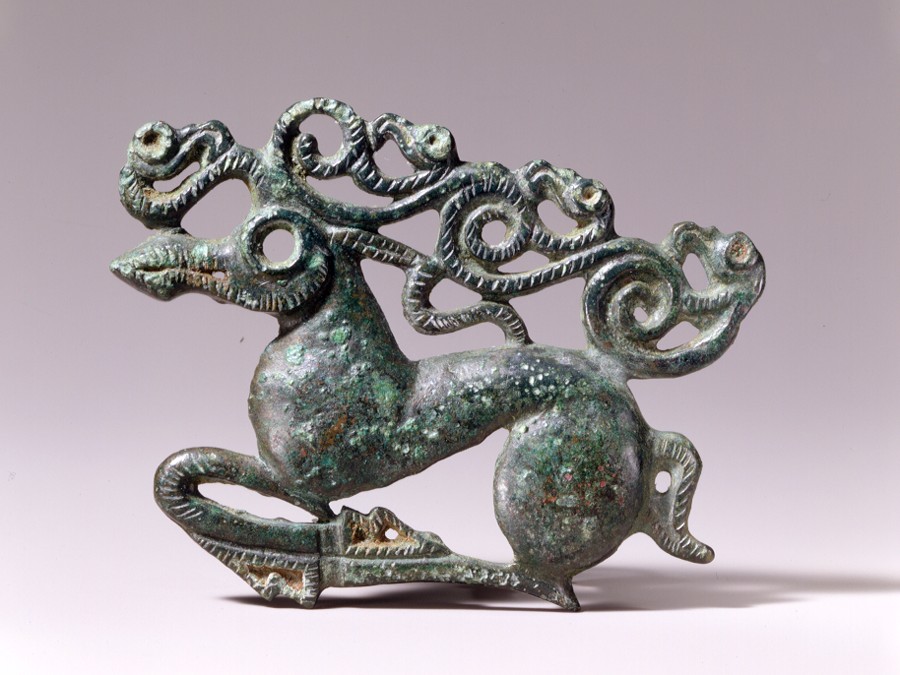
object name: garment plaque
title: Garment Plaque in the Shape of a Stag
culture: kazakh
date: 600-401 BCE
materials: bronze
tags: deer